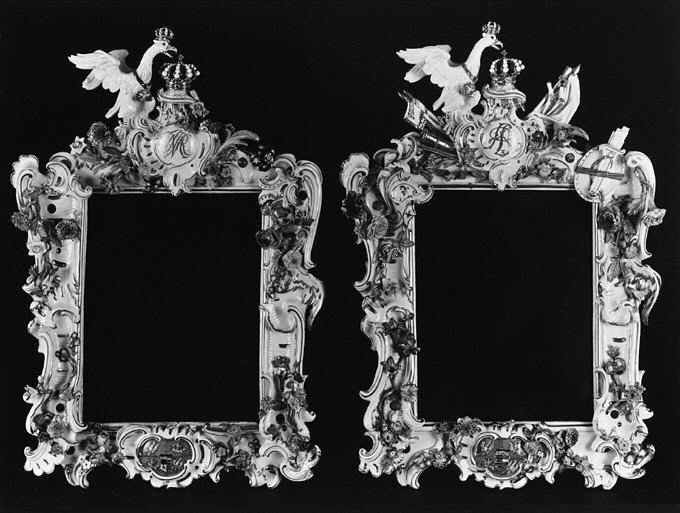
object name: mirror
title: Mirror (one of a pair)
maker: meissen manufactory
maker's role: manufactory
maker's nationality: german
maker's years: 1710-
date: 1750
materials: hard paste porcelain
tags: coat of arms